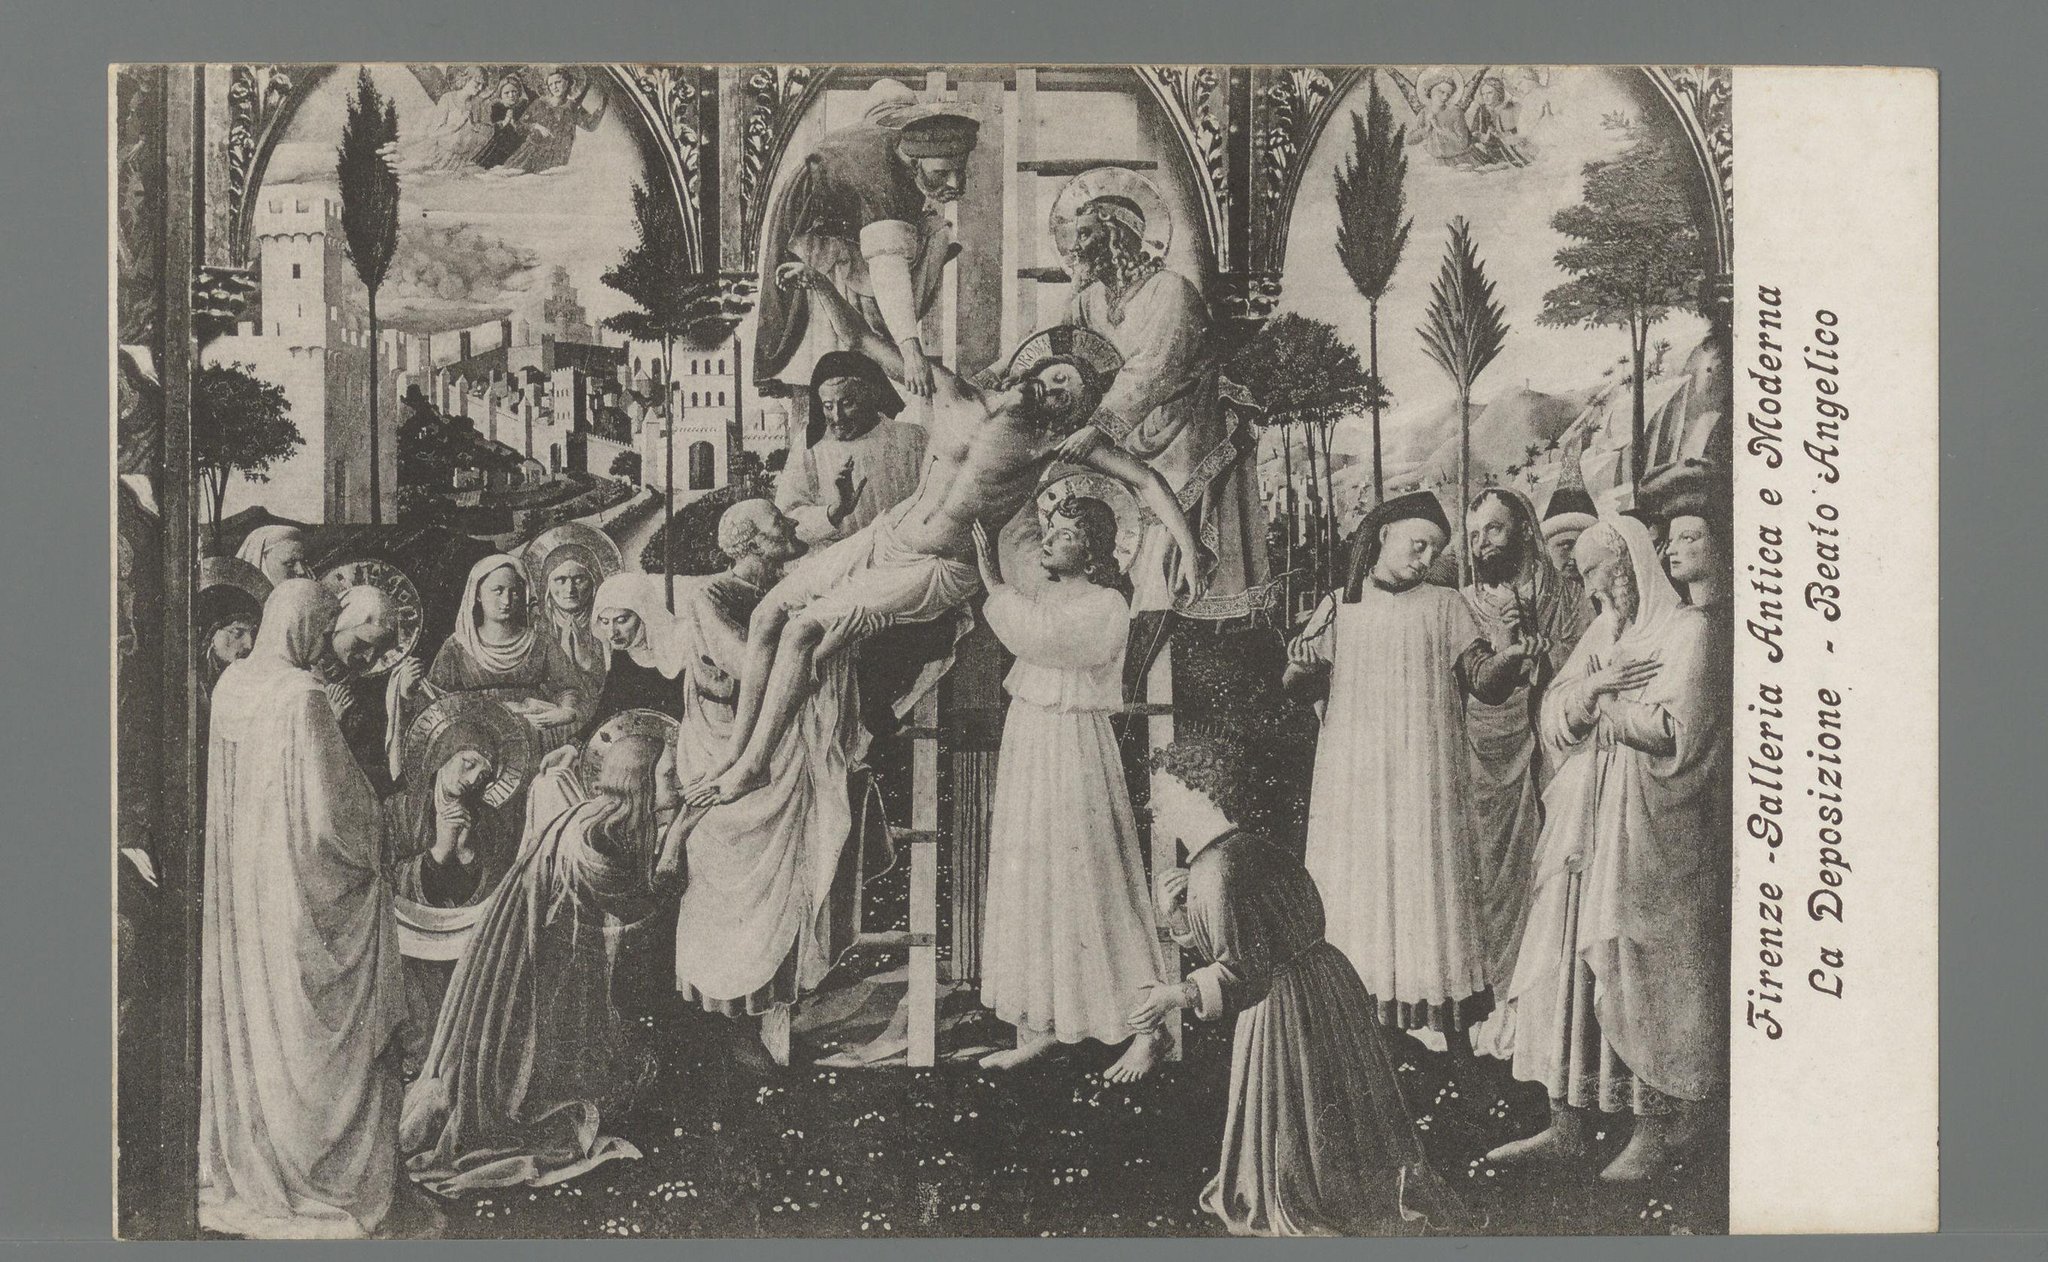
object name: photomechanical print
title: Firenze - Galleria Antica e Moderna. La Deposizione - Beato Angelico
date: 1906-1930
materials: cardboard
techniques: photograph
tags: permanent exhibition, museum, picture, painting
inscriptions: monogram, collector's mark: ‘AFE v S’